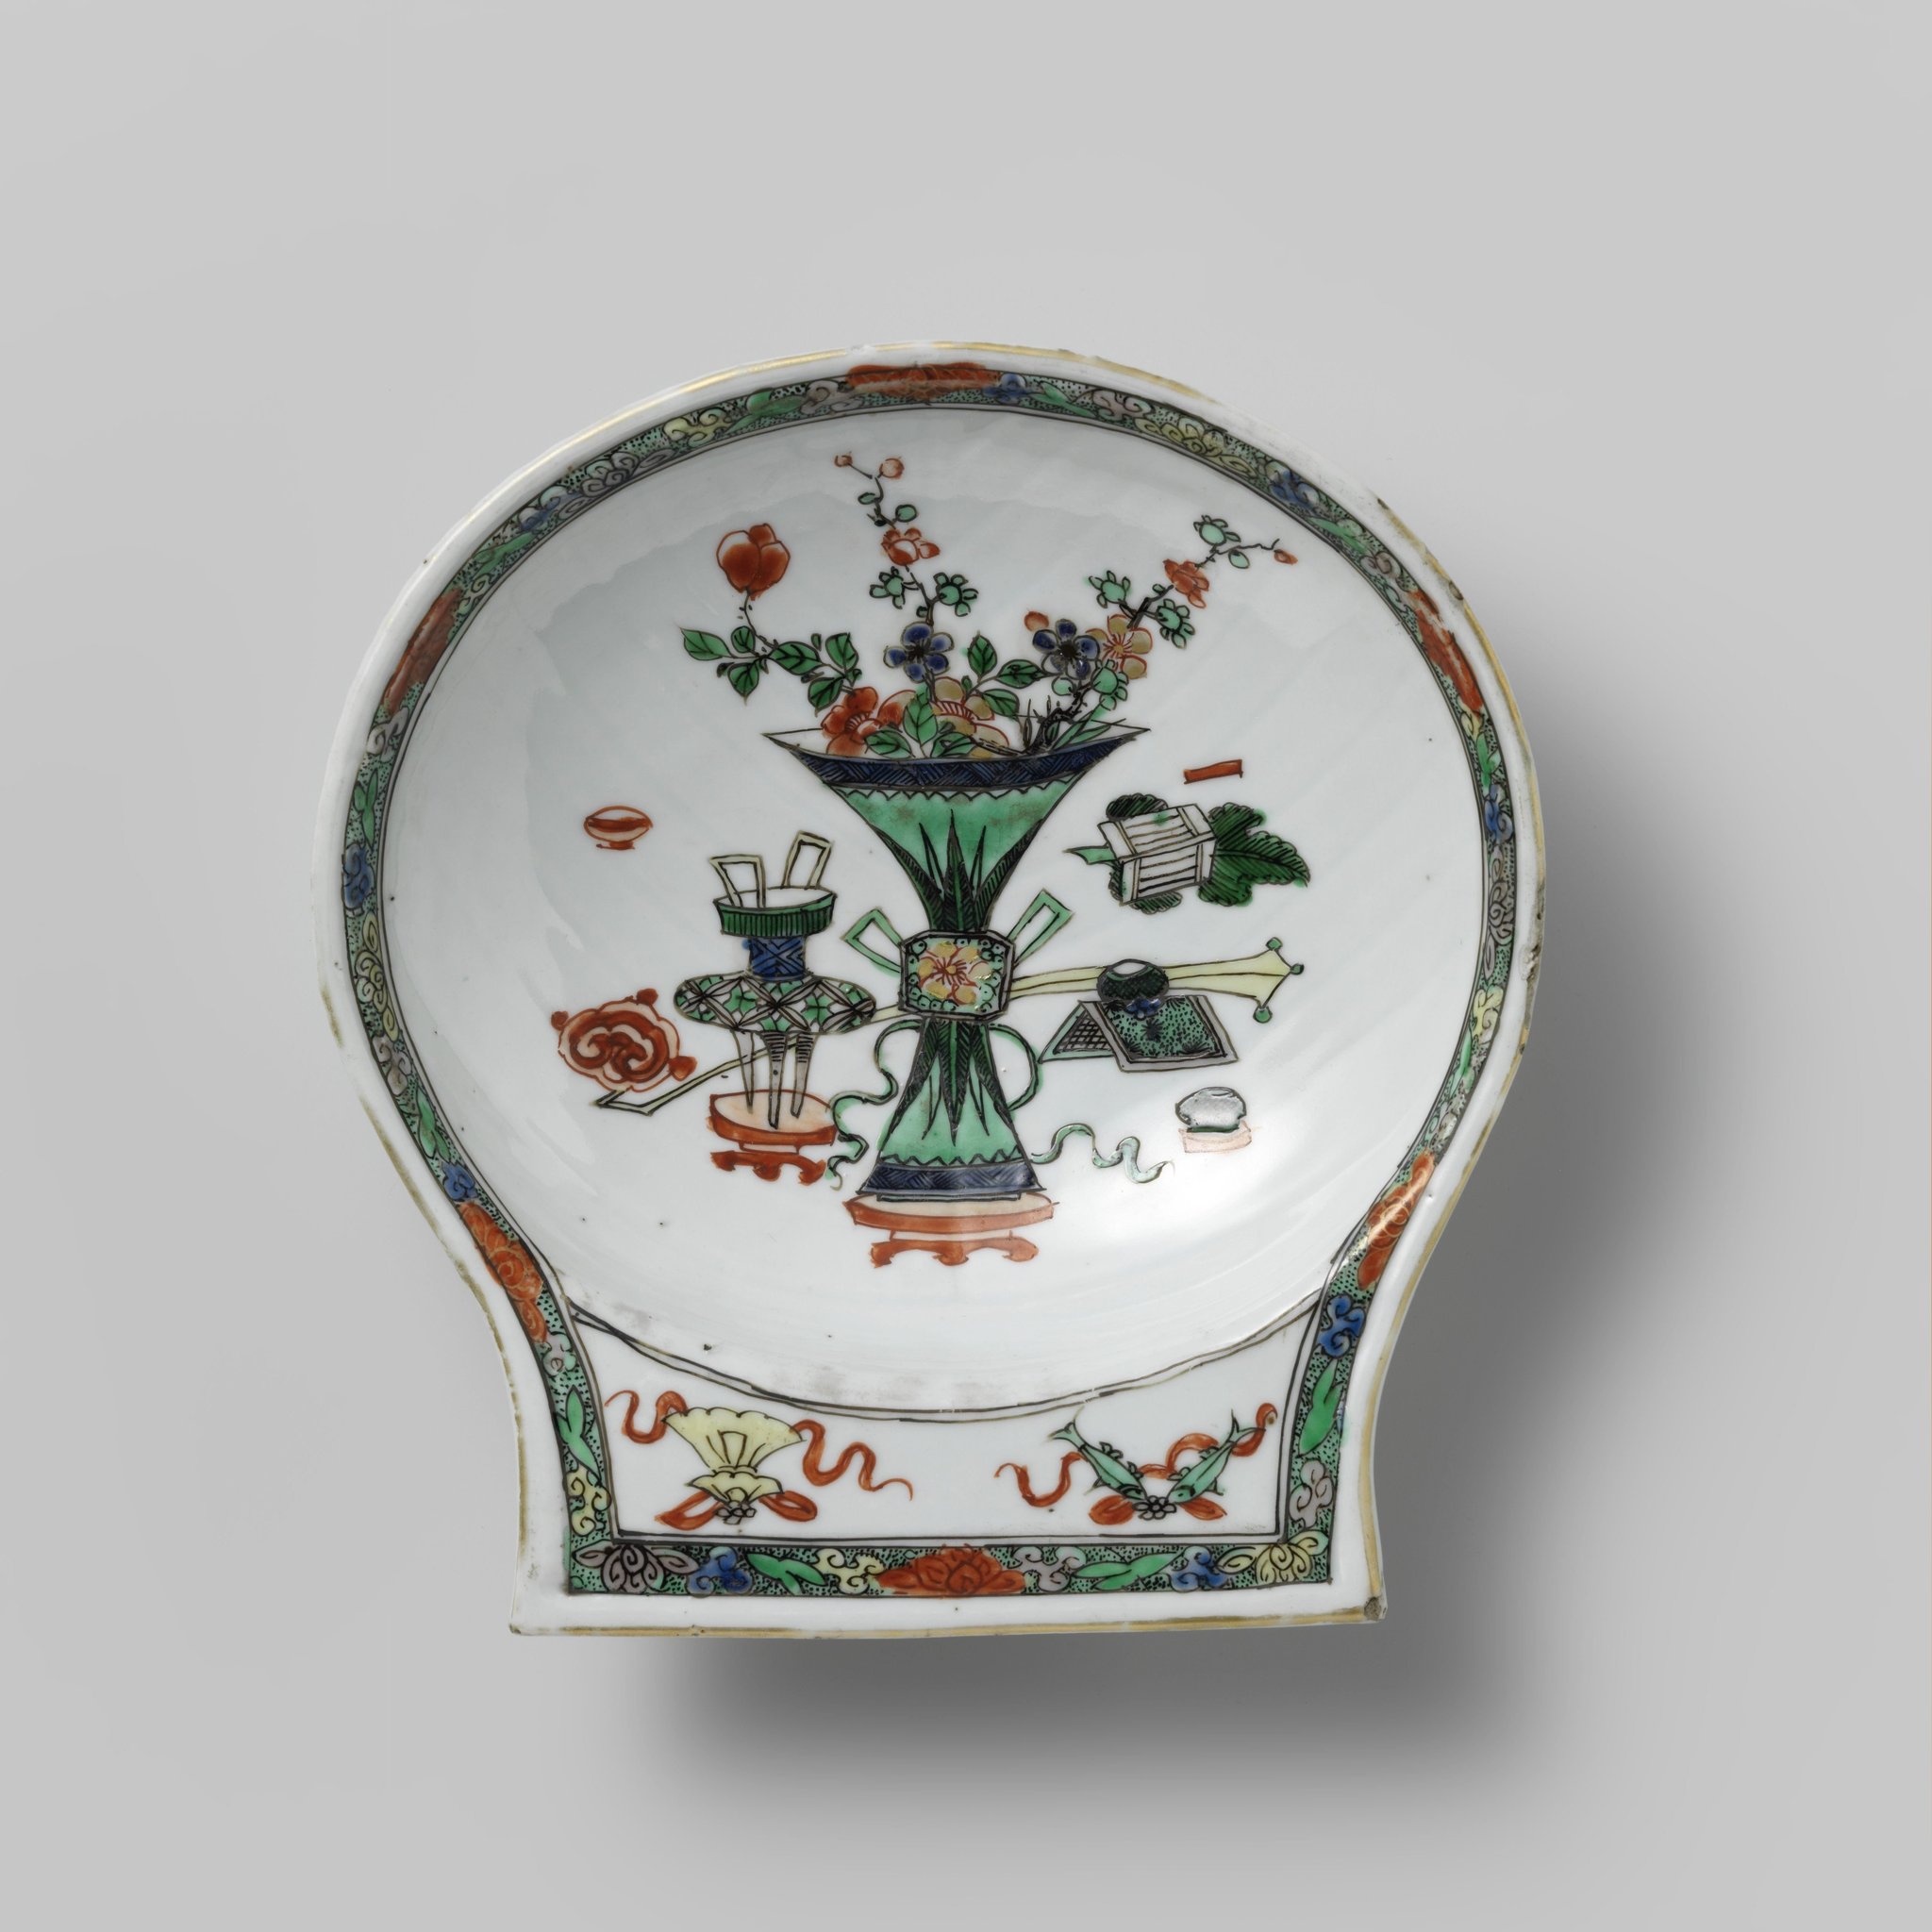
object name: bowl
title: Scallop-shell-shaped bowl with antiquities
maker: Anonymous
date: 1700-1724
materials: cobalt, glaze, gold, paint, porcelain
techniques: firing, forming, gilding, vitrification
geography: china